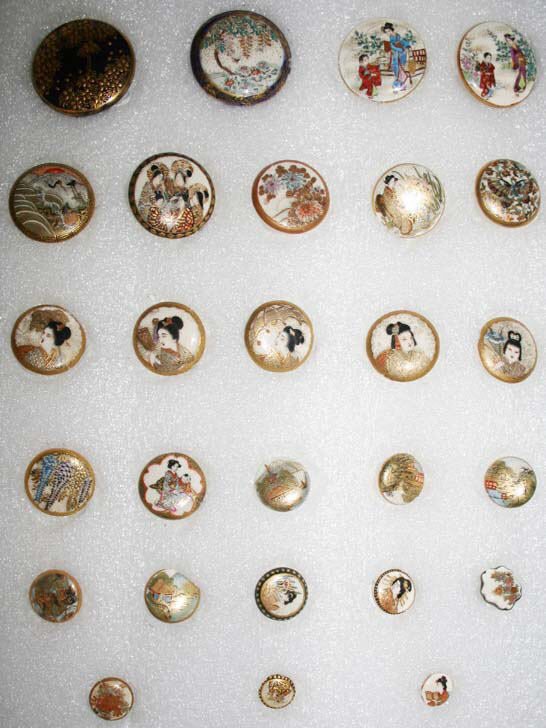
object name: button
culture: japanese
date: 1850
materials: porcelain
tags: children,women